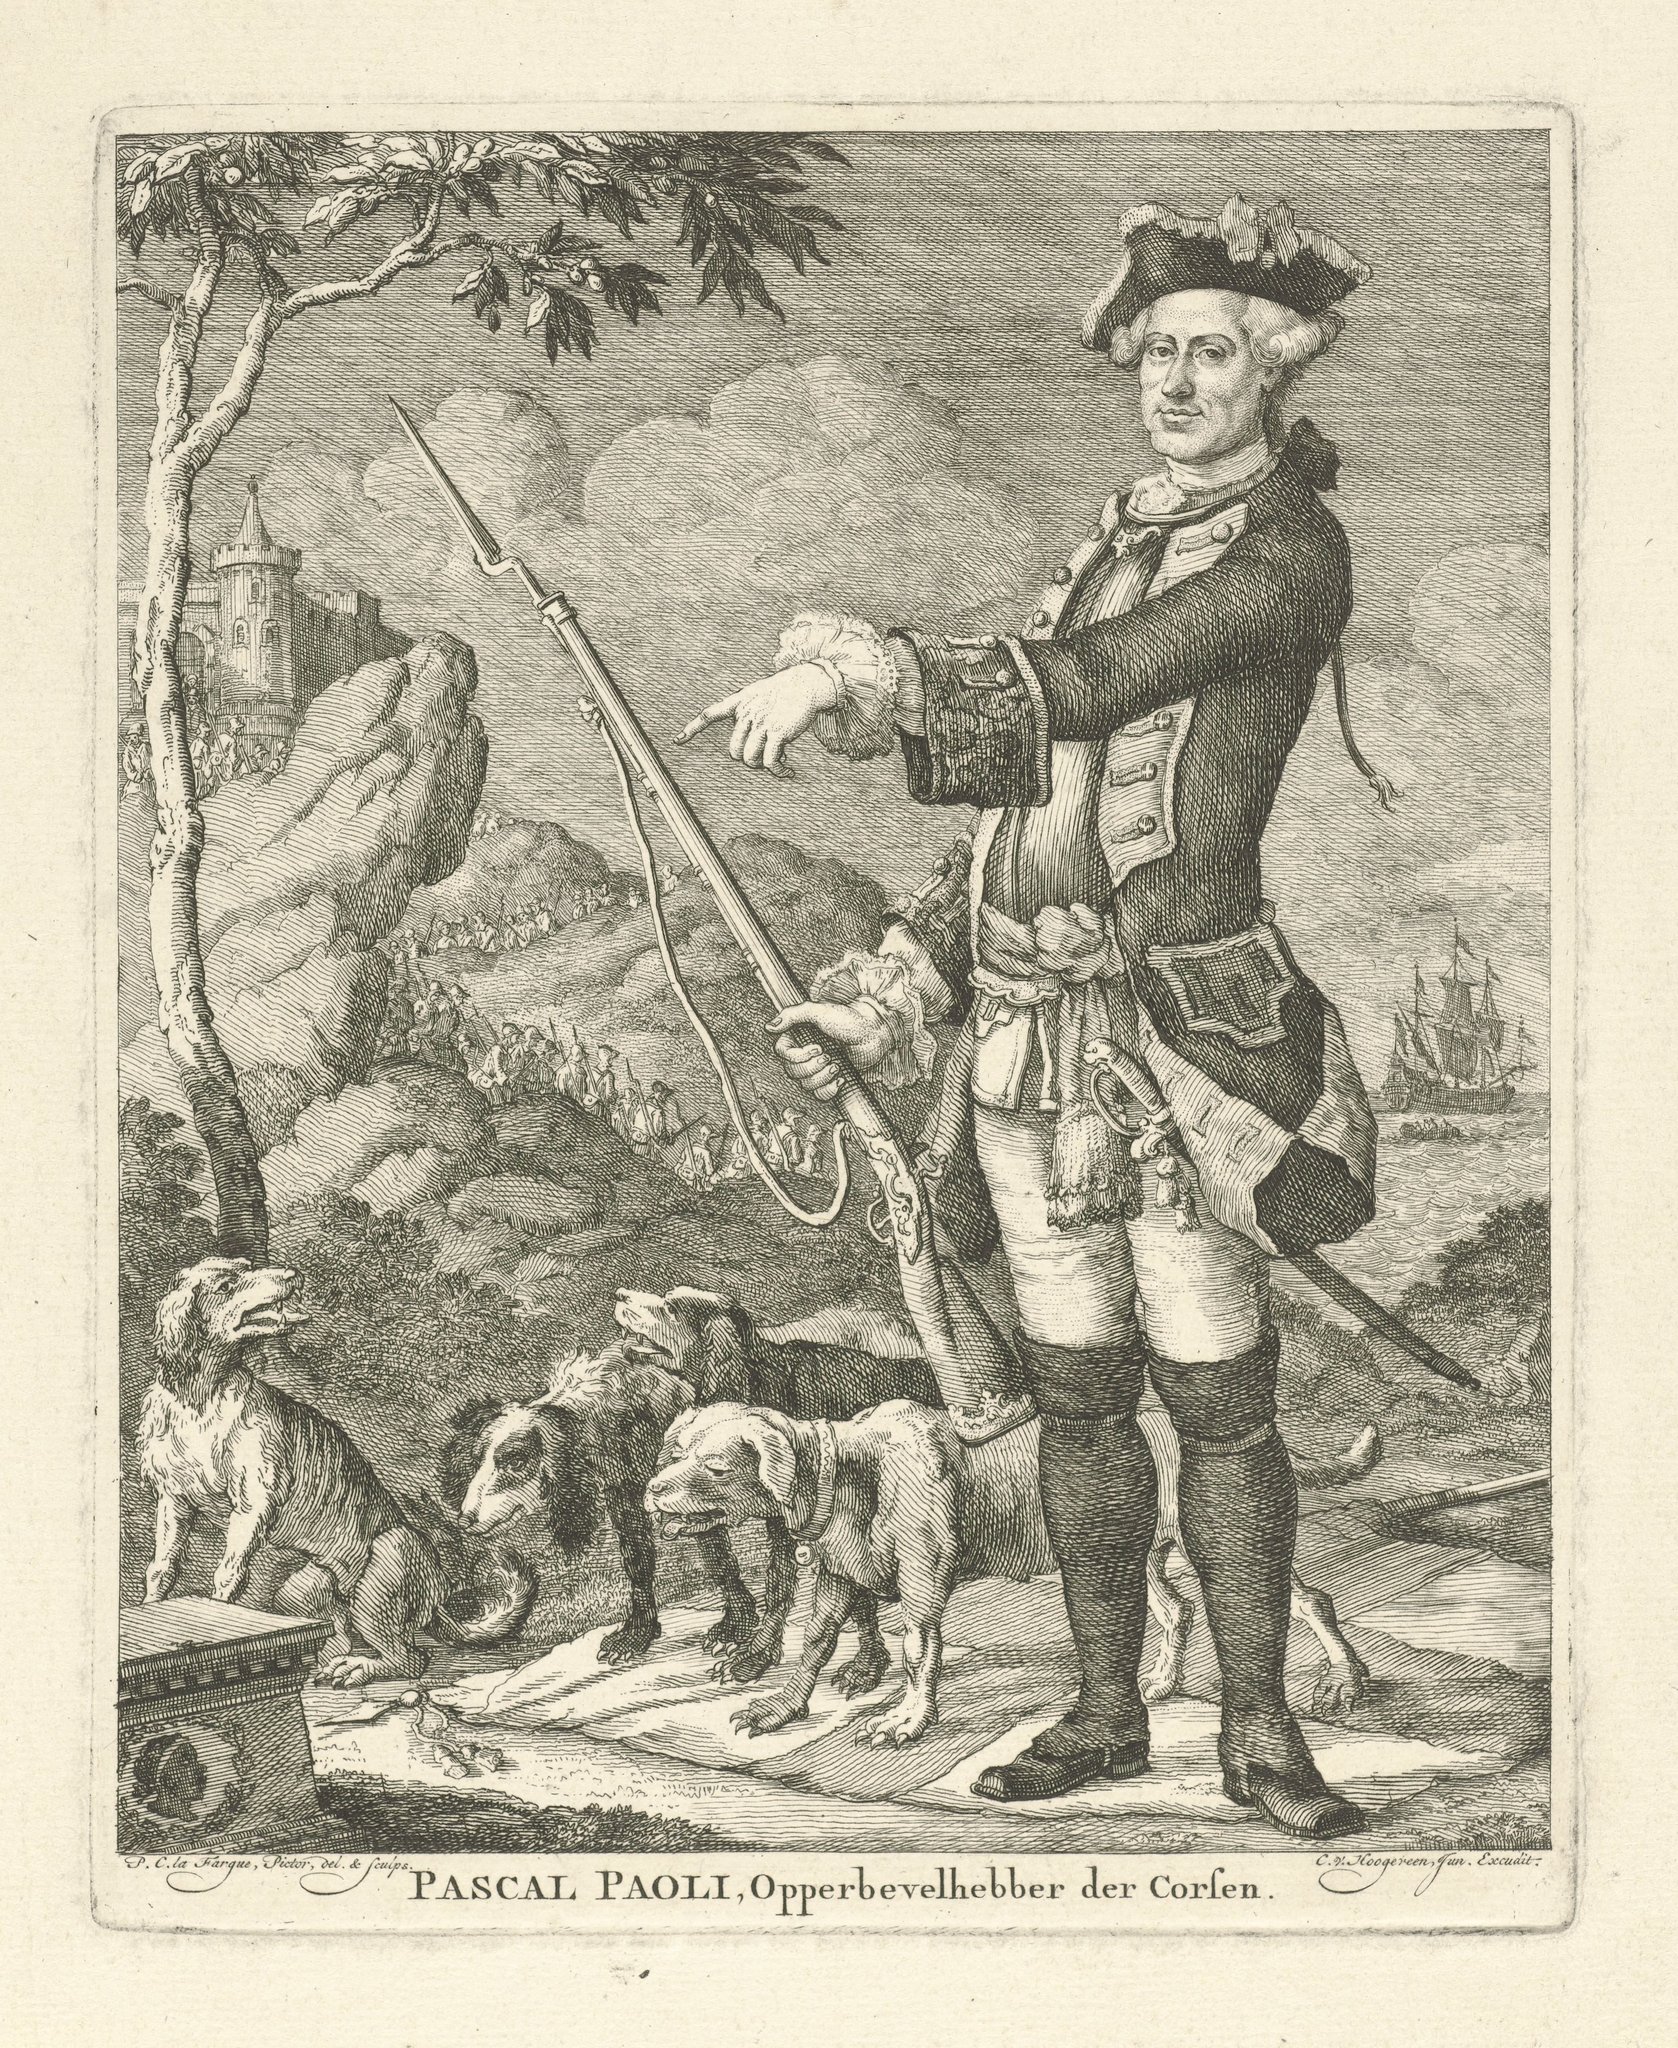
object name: print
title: Pascal Paoli, Opperbevelhebber der Corsen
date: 1761-1785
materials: paper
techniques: etching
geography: leiden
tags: london, army 'en route', commander-in-chief, general, marshal, rocky coast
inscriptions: collector's mark: Lugt 2228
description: Pascal Paoli, leider der Corsicanen, staat in het gezelschap van vier honden op de Genuaanse vlag in een rotsachtig landschap. In zijn hand houdt Paoli een musket met bajonet, met zijn vrije hand maakt hij een wijzend gebaar. In de verte lopen troepen soldaten (links) en vaart een zeilschip op zee (rechts).